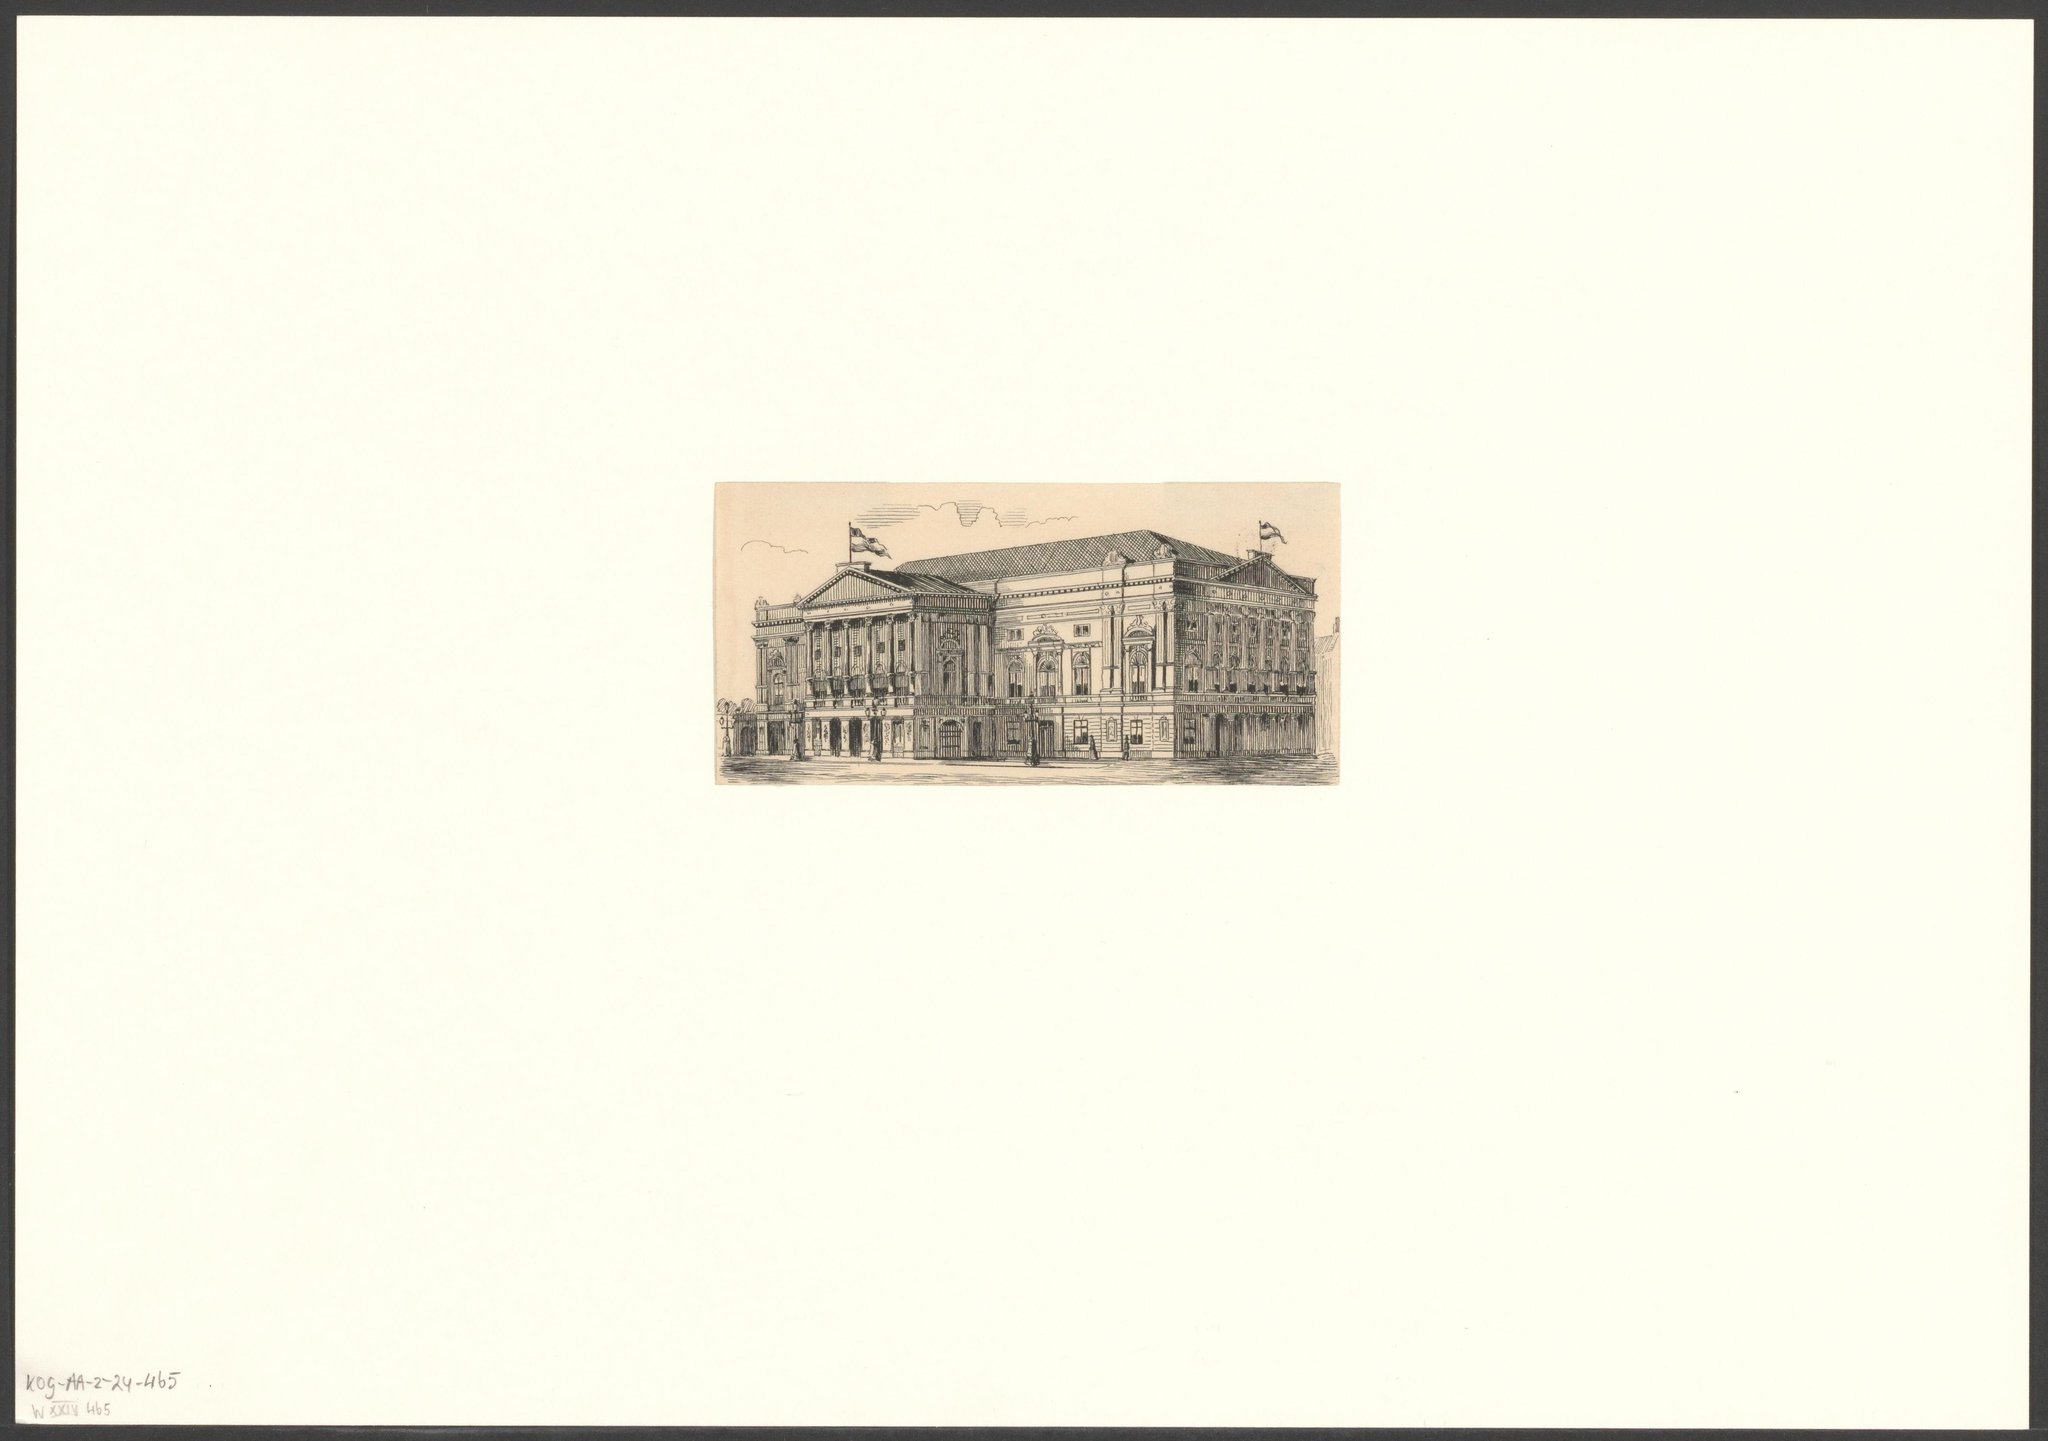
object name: drawing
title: Gezicht op de Stadsschouwburg aan het Leidseplein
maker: johan conrad greive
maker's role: draughtsman, painter, print maker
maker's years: 1837-1891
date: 1847-1890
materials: ink, paper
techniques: pen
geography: amsterdam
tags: city-view in general; 'veduta', theatre (building)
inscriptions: collector's mark: Lugt 800a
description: Tekening binnen de Atlas Van Eck ingedeeld op wijknummer 24.